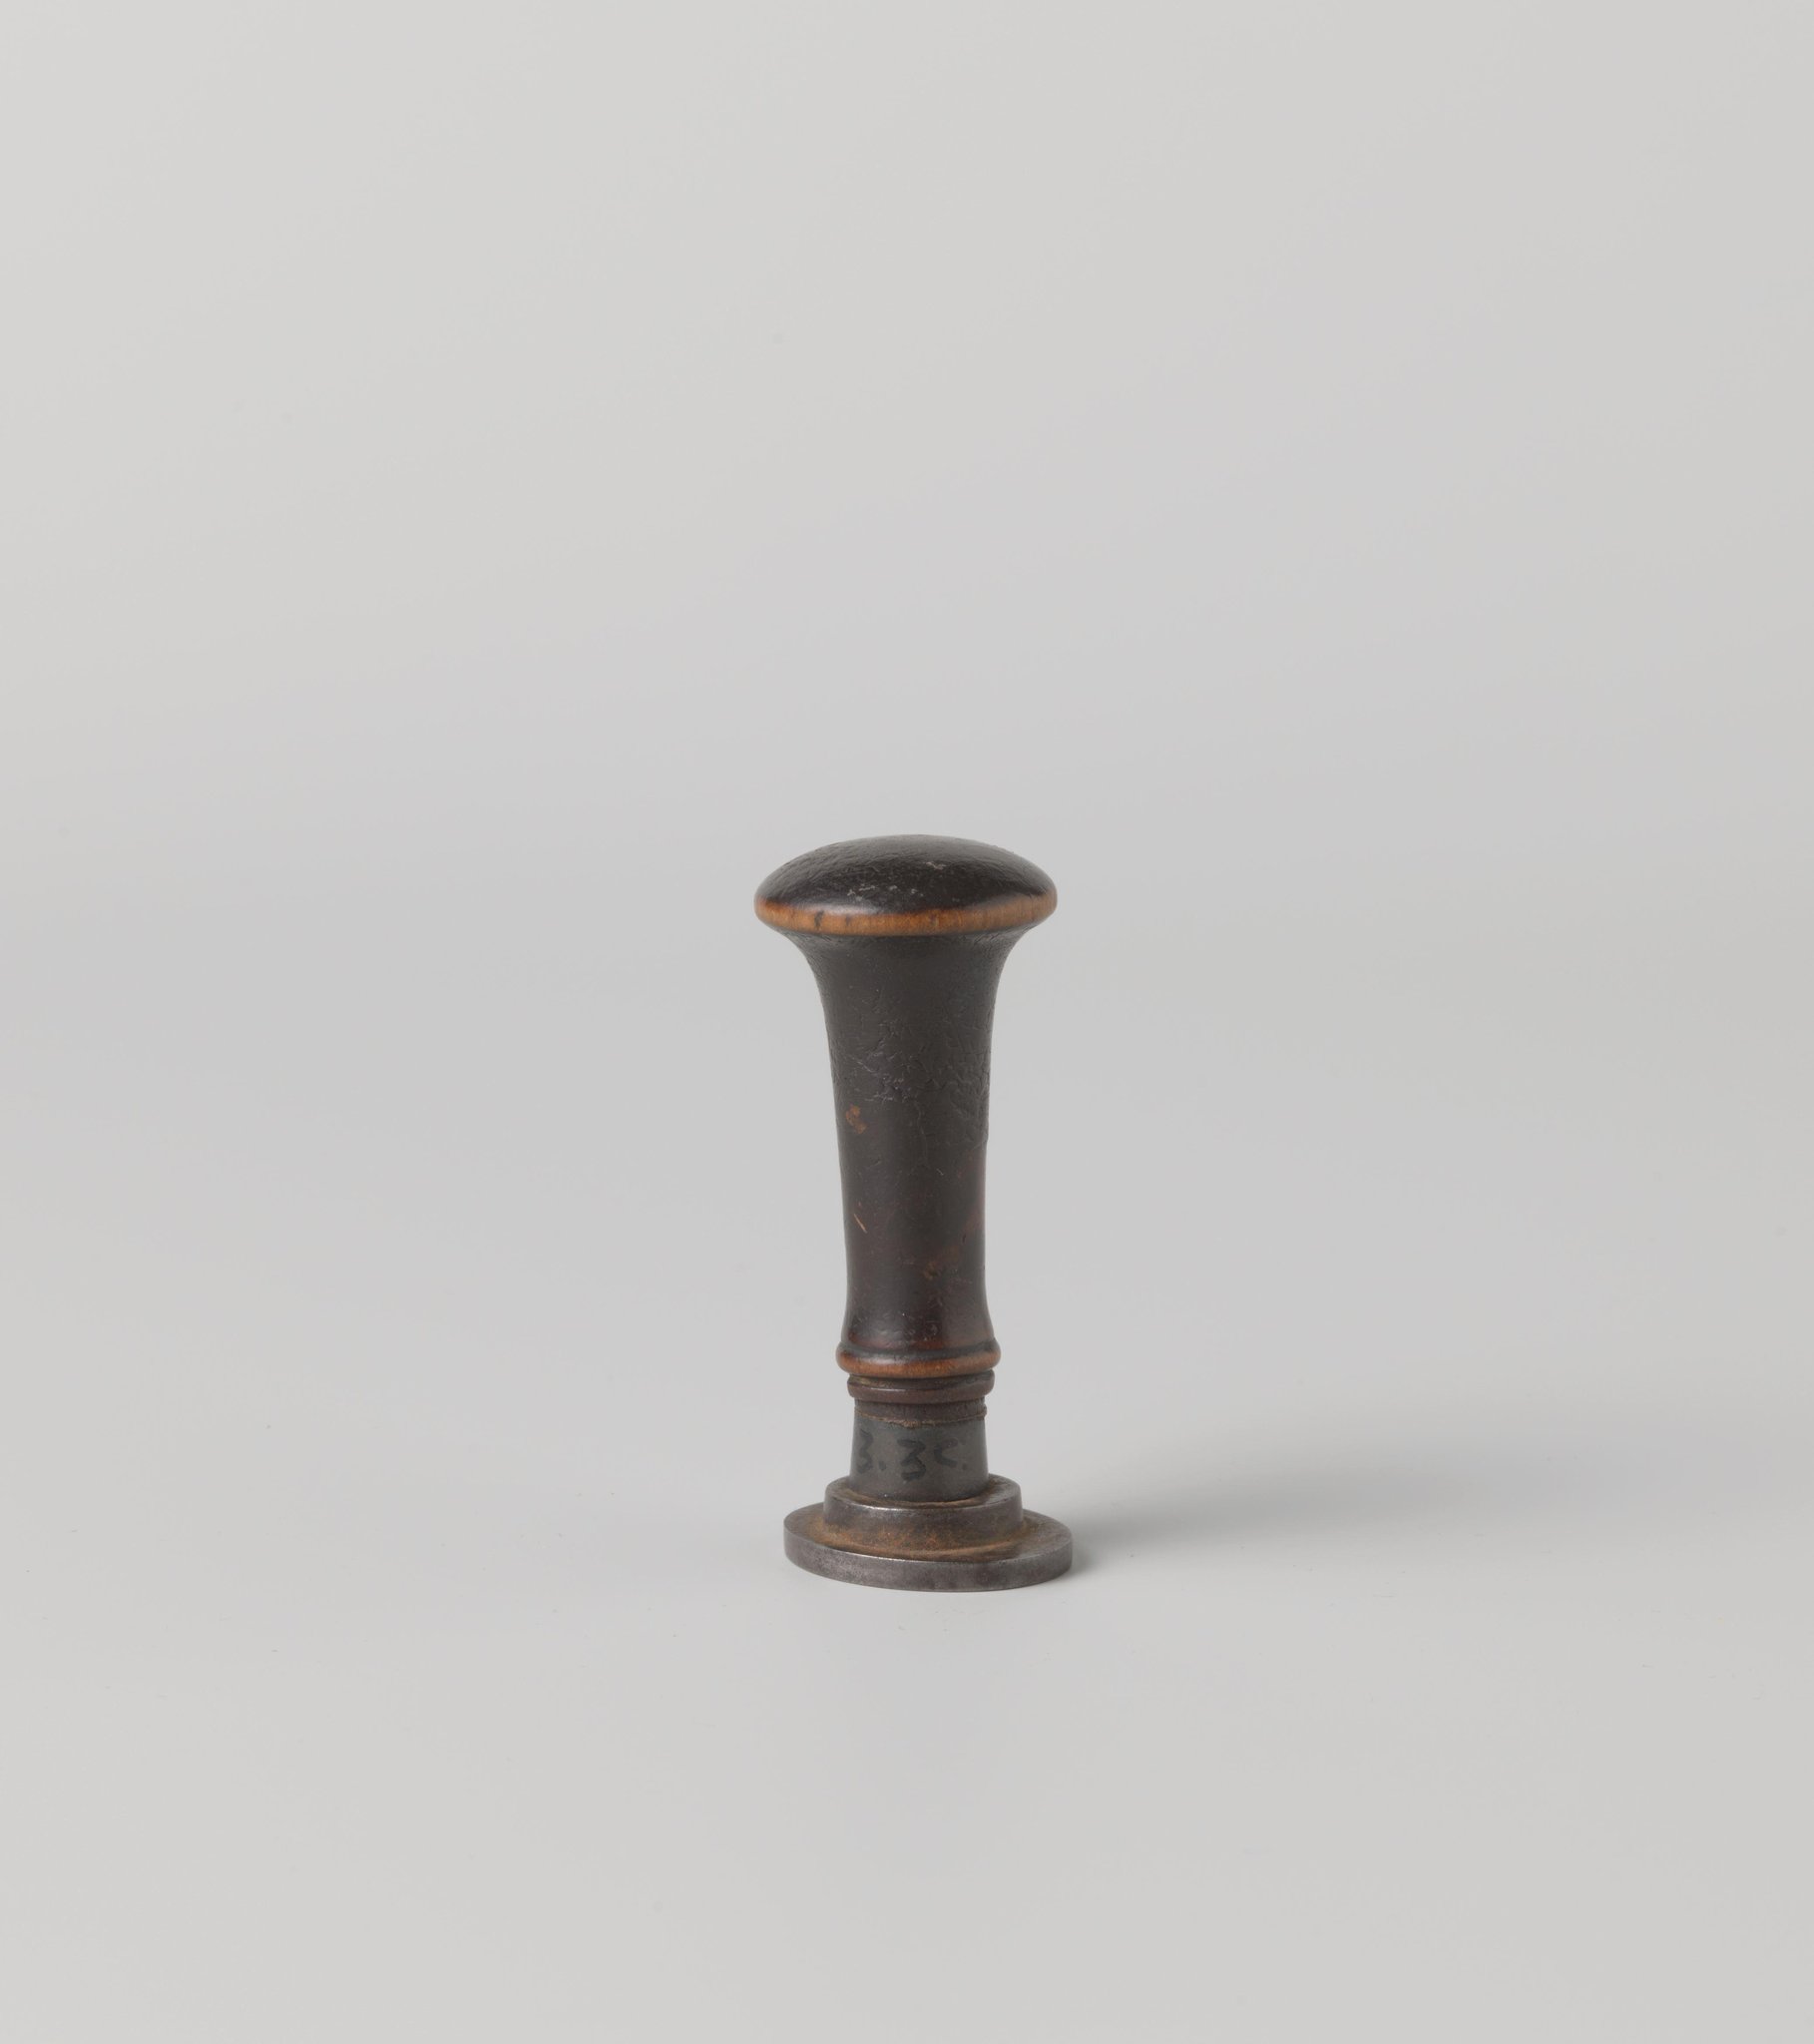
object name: zegelstempel, lakstempel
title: Zegelstempel Thorbecke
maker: Anonymous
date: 1800-1900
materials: copper, wood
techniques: turning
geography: netherlands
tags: the hague, johan rudolf thorbecke, netherlands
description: Ovalen koperen zegel met houten handvat waarop wapenschild met zwemmende vis naar rechts op water. Gevleugeld helmteken.